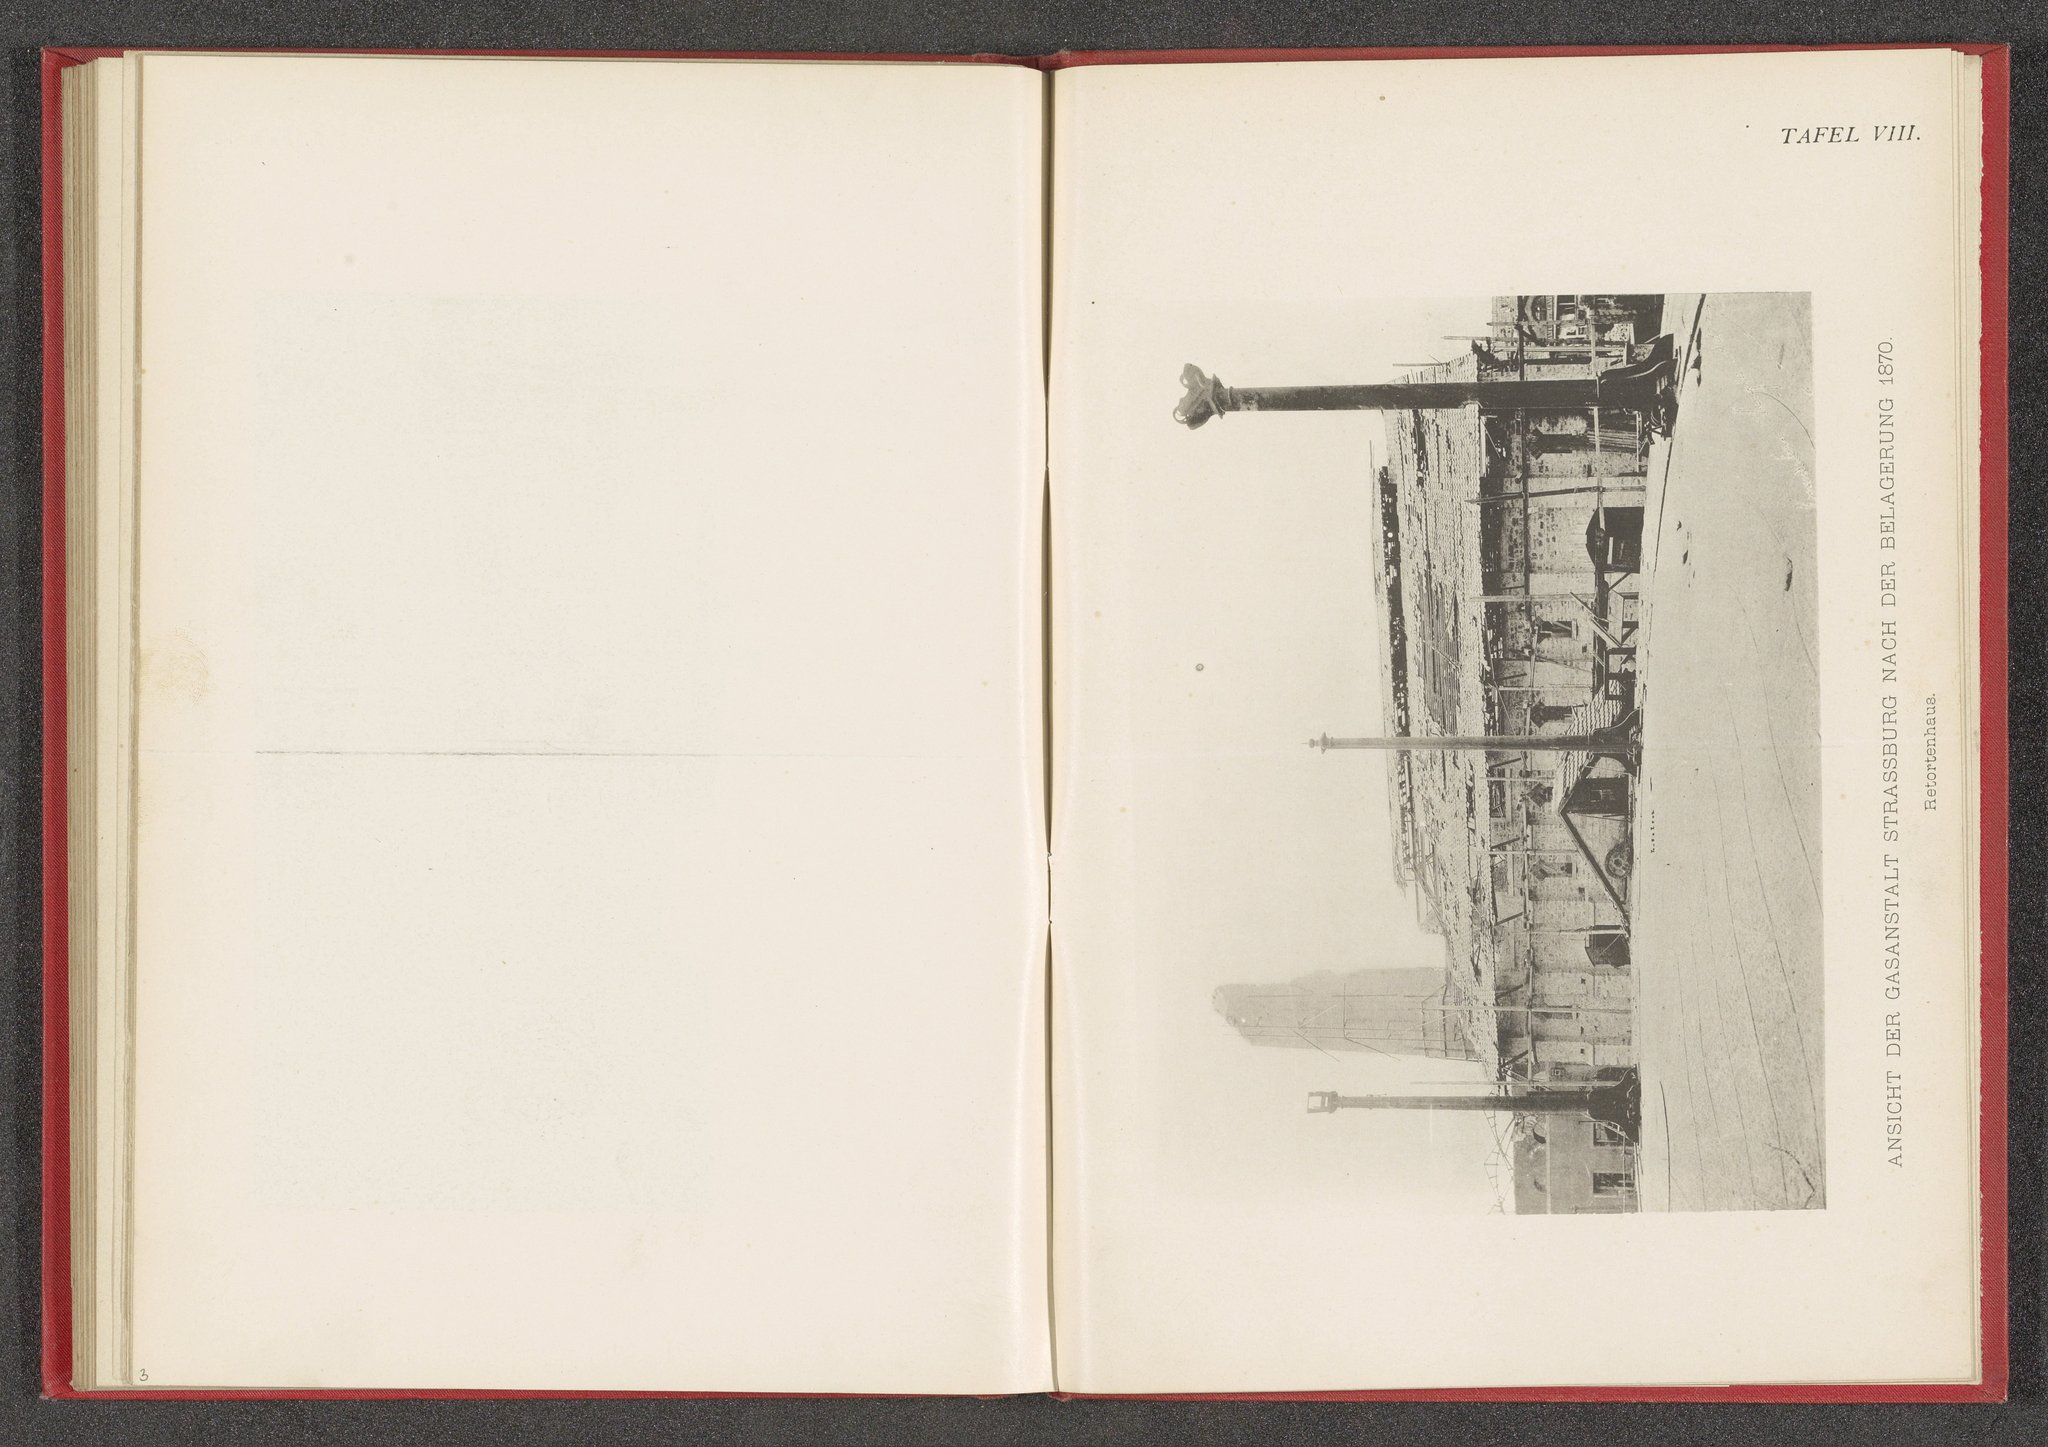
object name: page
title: Ansicht der gasanstalt Strassburg nach der belagerung 1870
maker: Anonymous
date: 1870-1891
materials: paper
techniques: photograph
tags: gasworks, ruin of a building ~ architecture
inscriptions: number: ‘Tafel VIII.’, inscription: ‘Retortenhaus.’